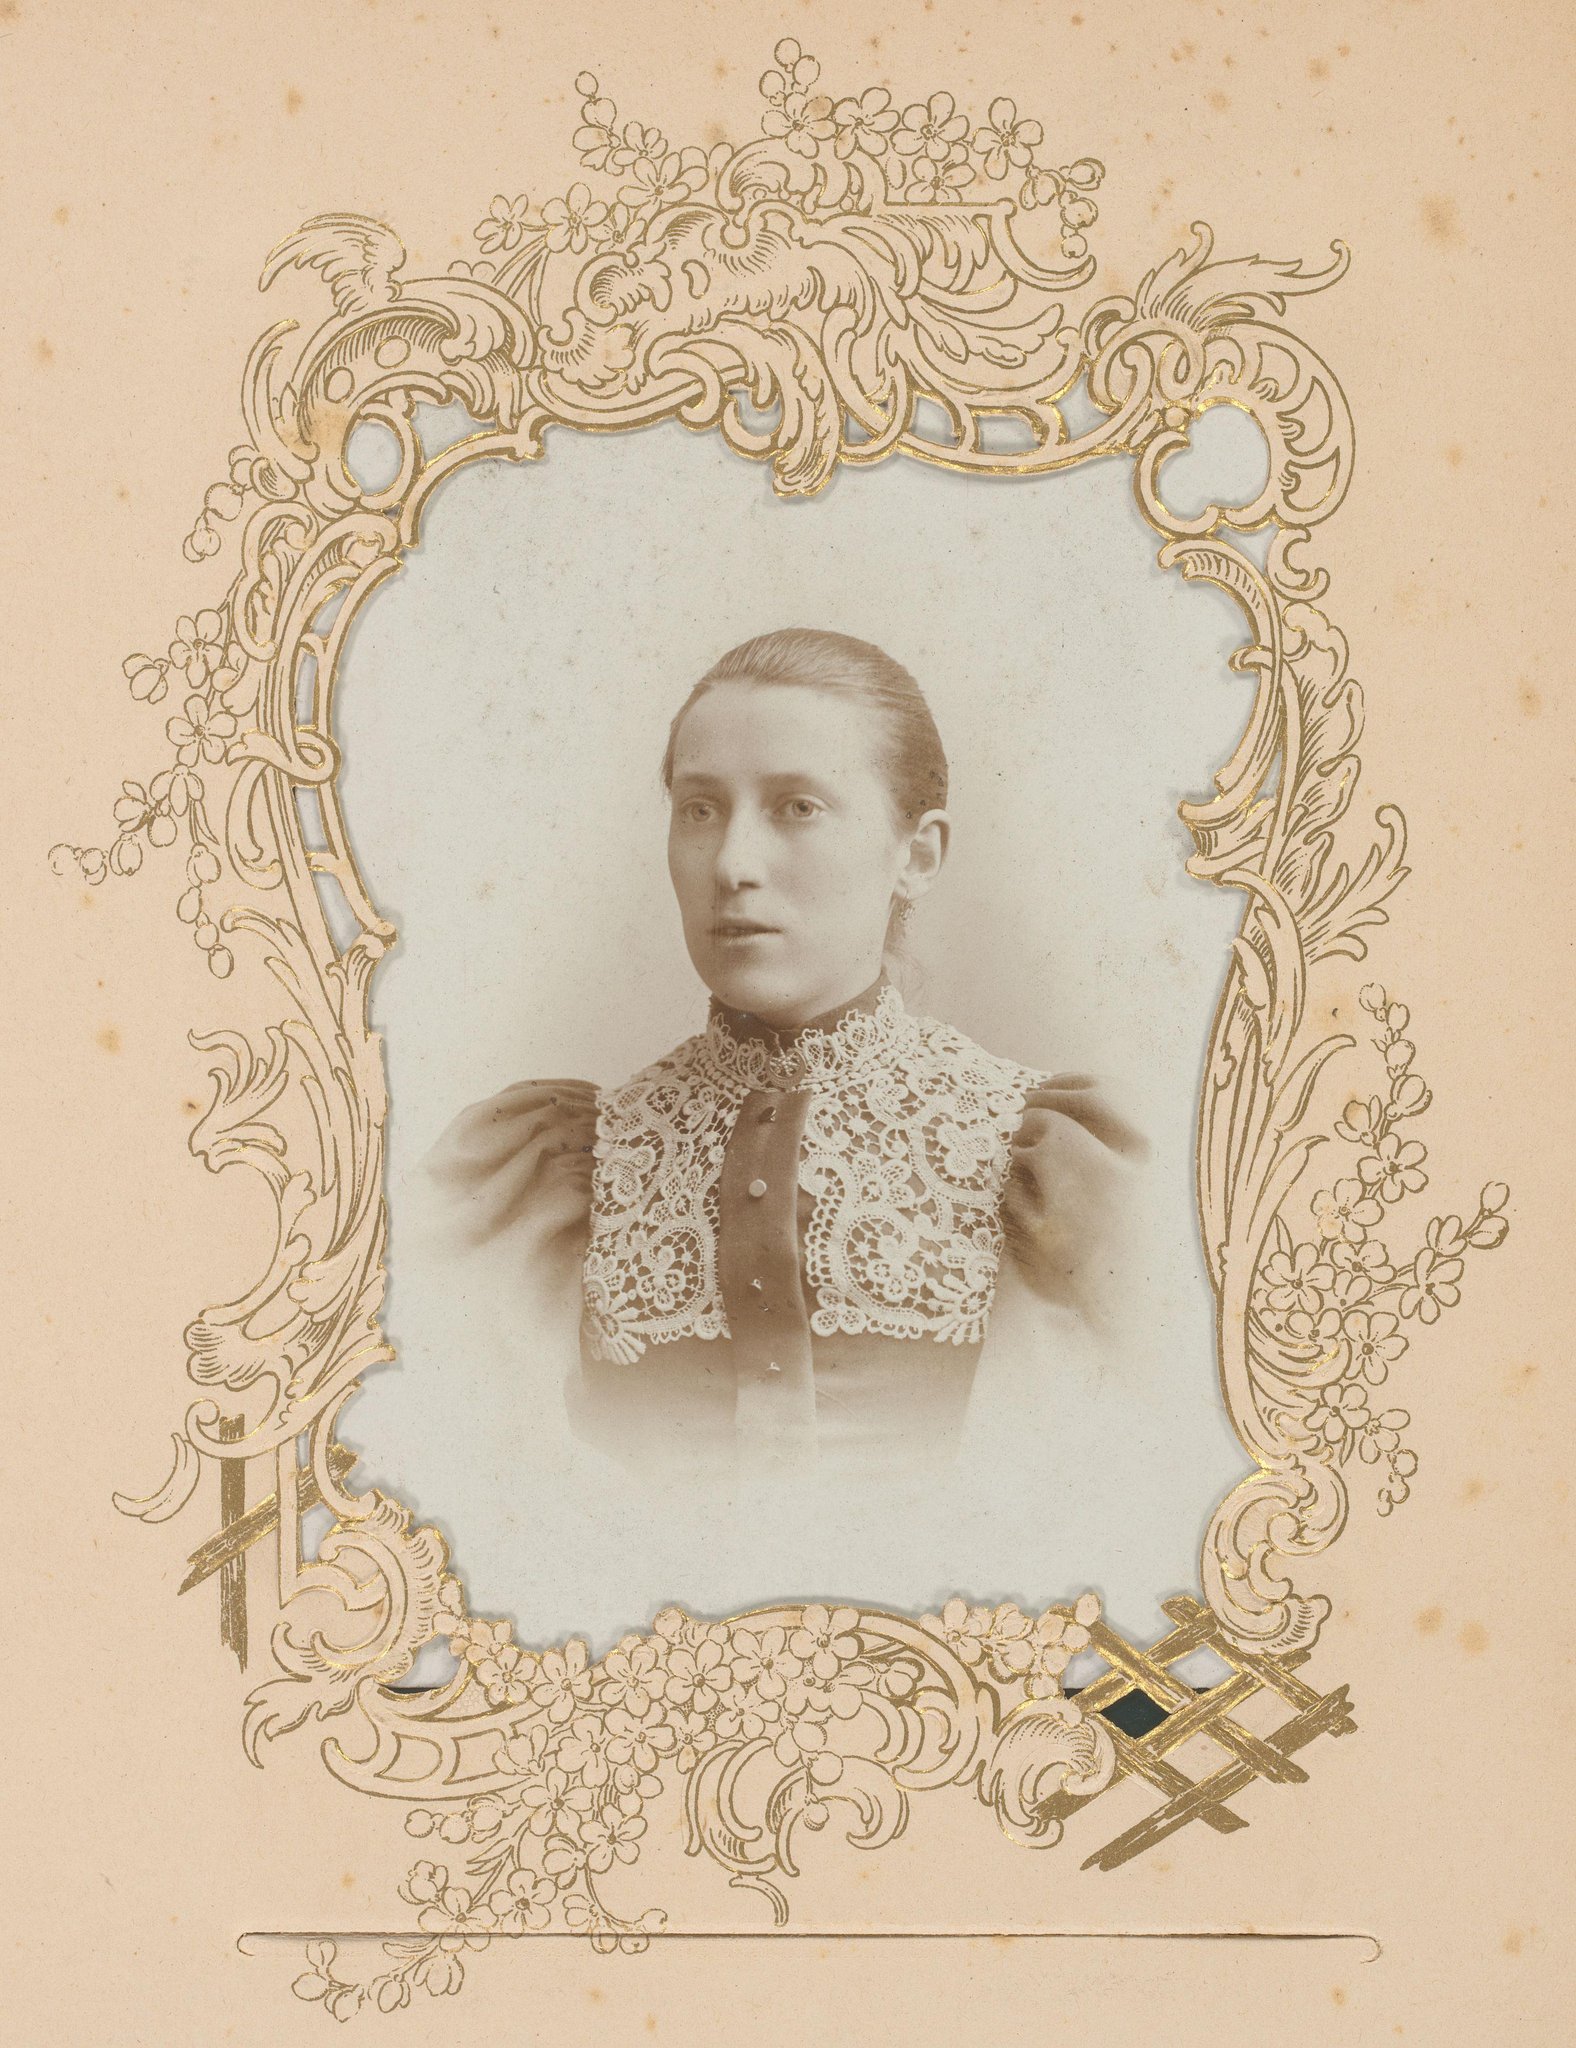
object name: photograph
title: Portret van een vrouw met kanten kraag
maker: Anonymous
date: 1880-1910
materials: cardboard, photographic support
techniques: collodion silver print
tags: historical persons - bb - woman, border, ribbon, braid, lace